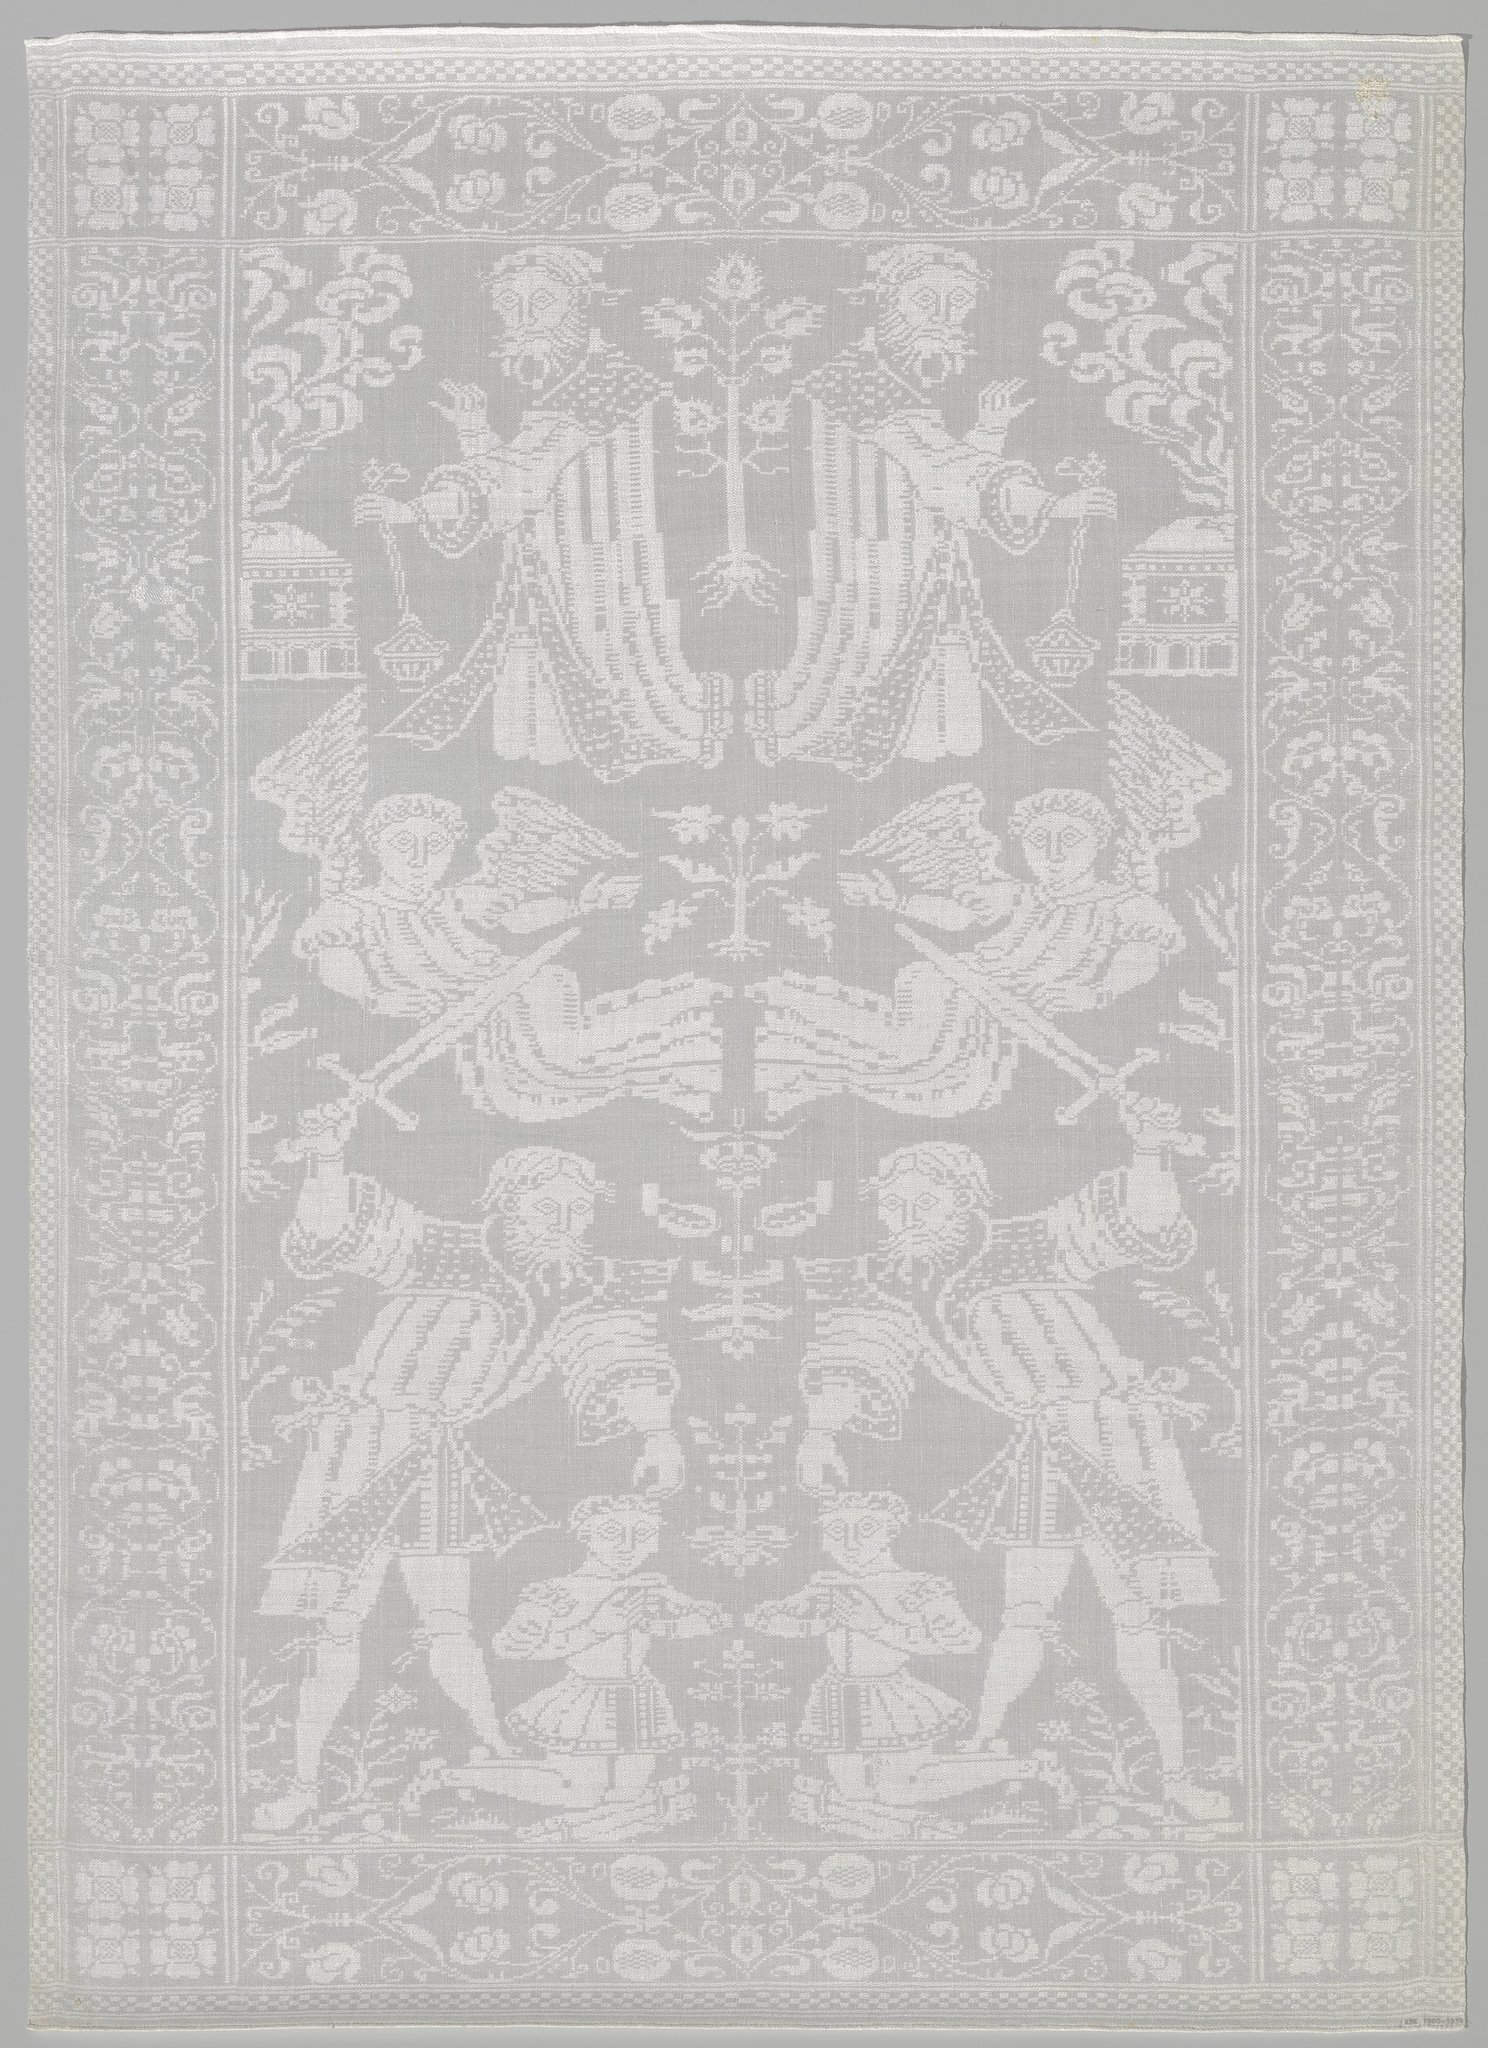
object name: napkin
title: Servet met het Offer van Abraham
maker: Anonymous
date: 1600-1625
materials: linen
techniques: damask, weave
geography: haarlem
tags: the sacrifice of isaac (genesis 22)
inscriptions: mark: ‘HW 23 K’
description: Servet van linnendamast met het Offer van Abraham. Middenveld: Offer van Abraham. Staande en liggende randen: gestapeld bloem- en bladornament en vogels; daarbuiten: blokkenrand. Hoeken: Tudorroos.